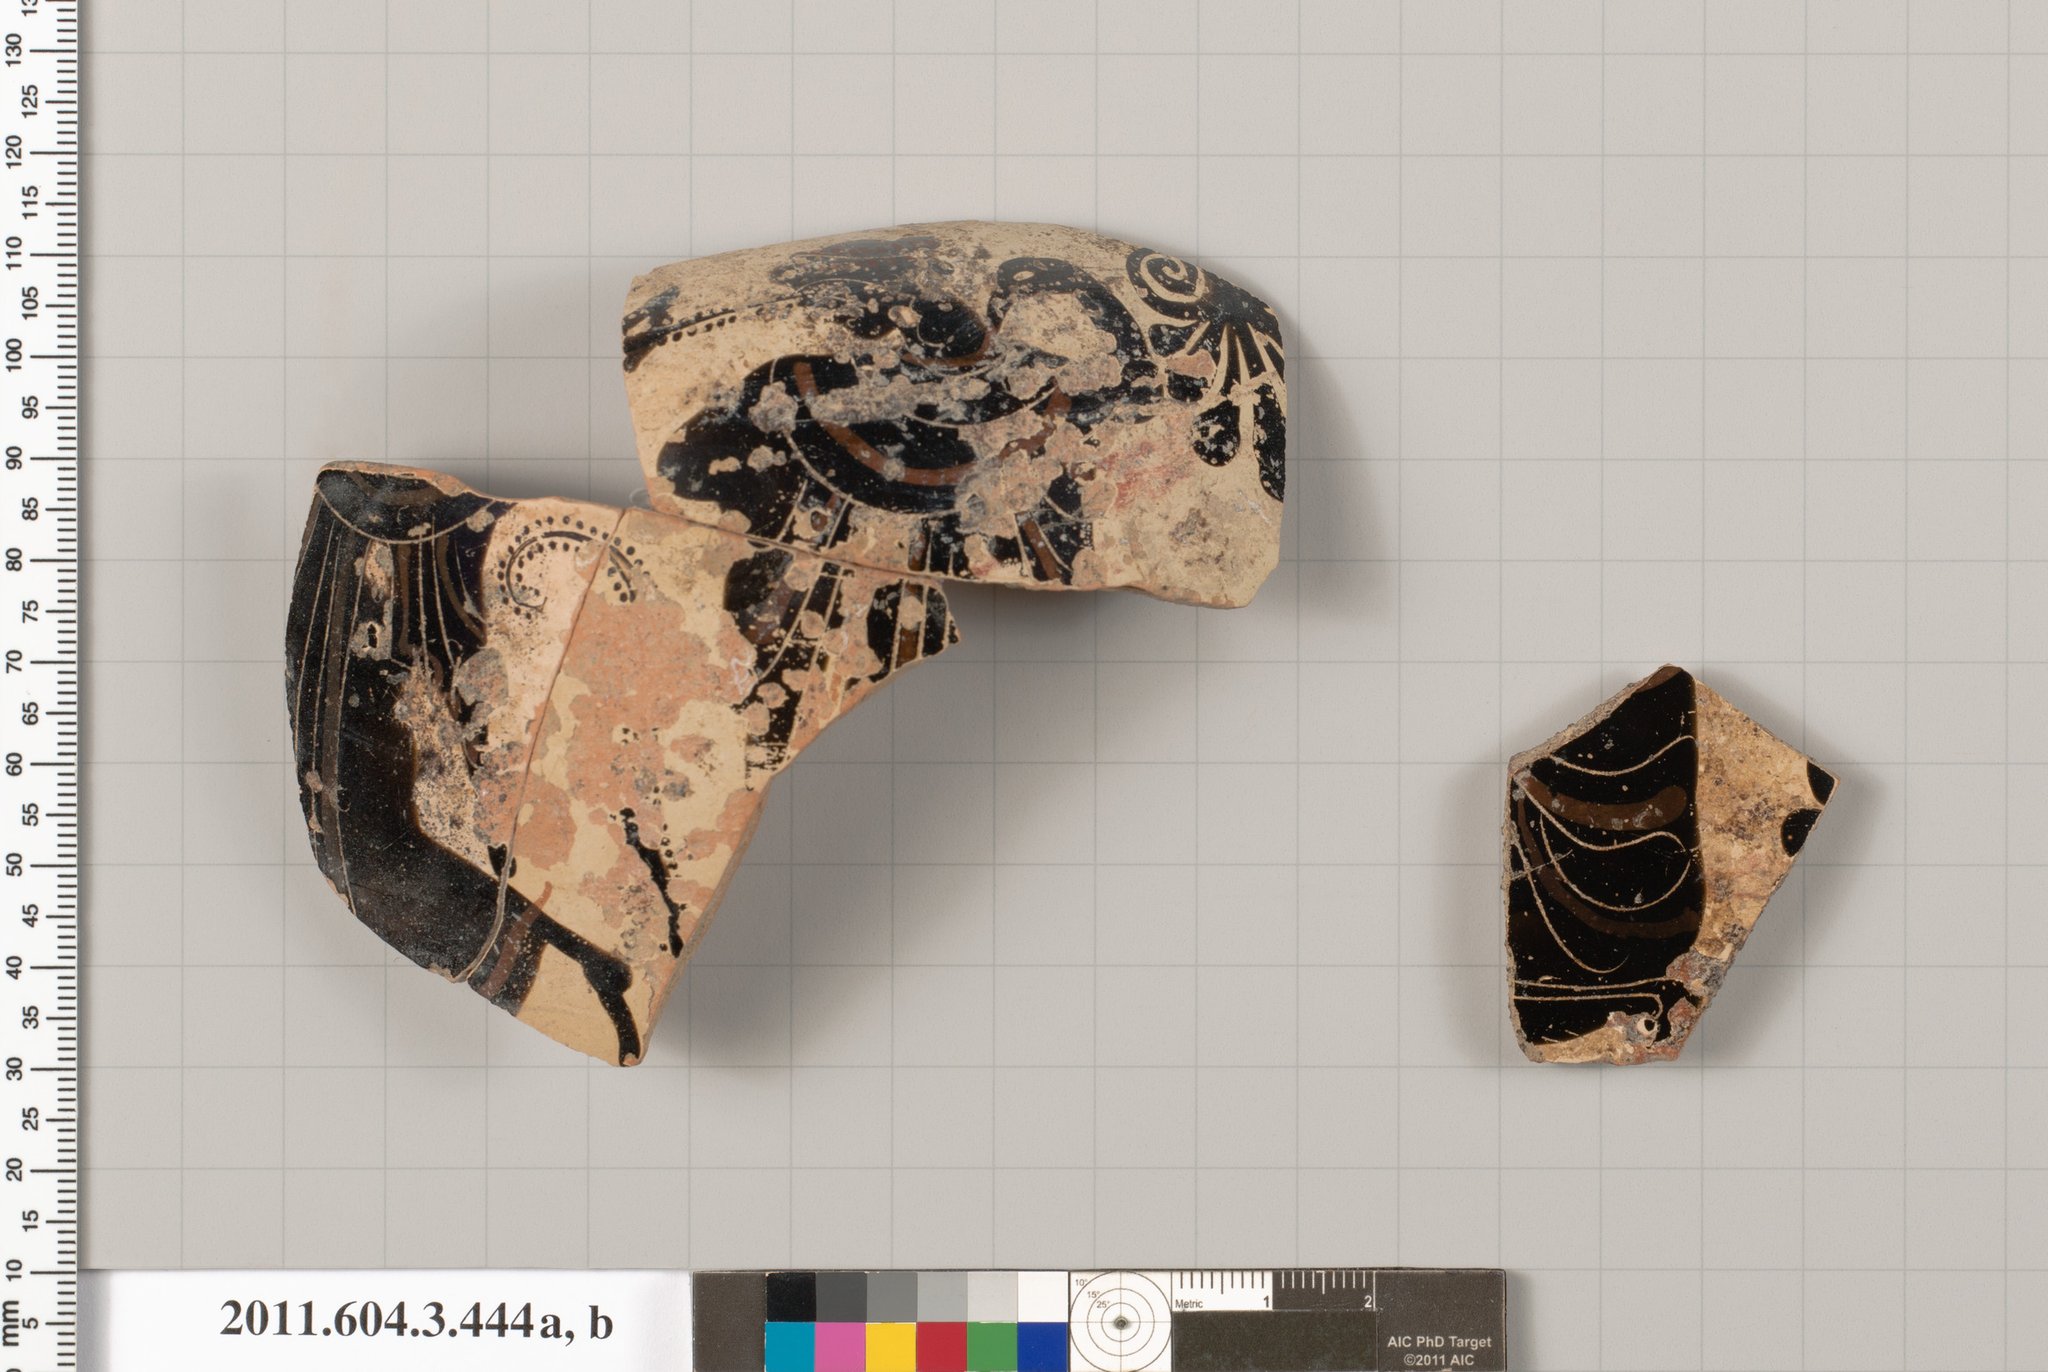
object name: neck amphora fragment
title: Terracotta fragments of a neck-amphora (jar)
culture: greek, attic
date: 490-480 BCE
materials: terracotta